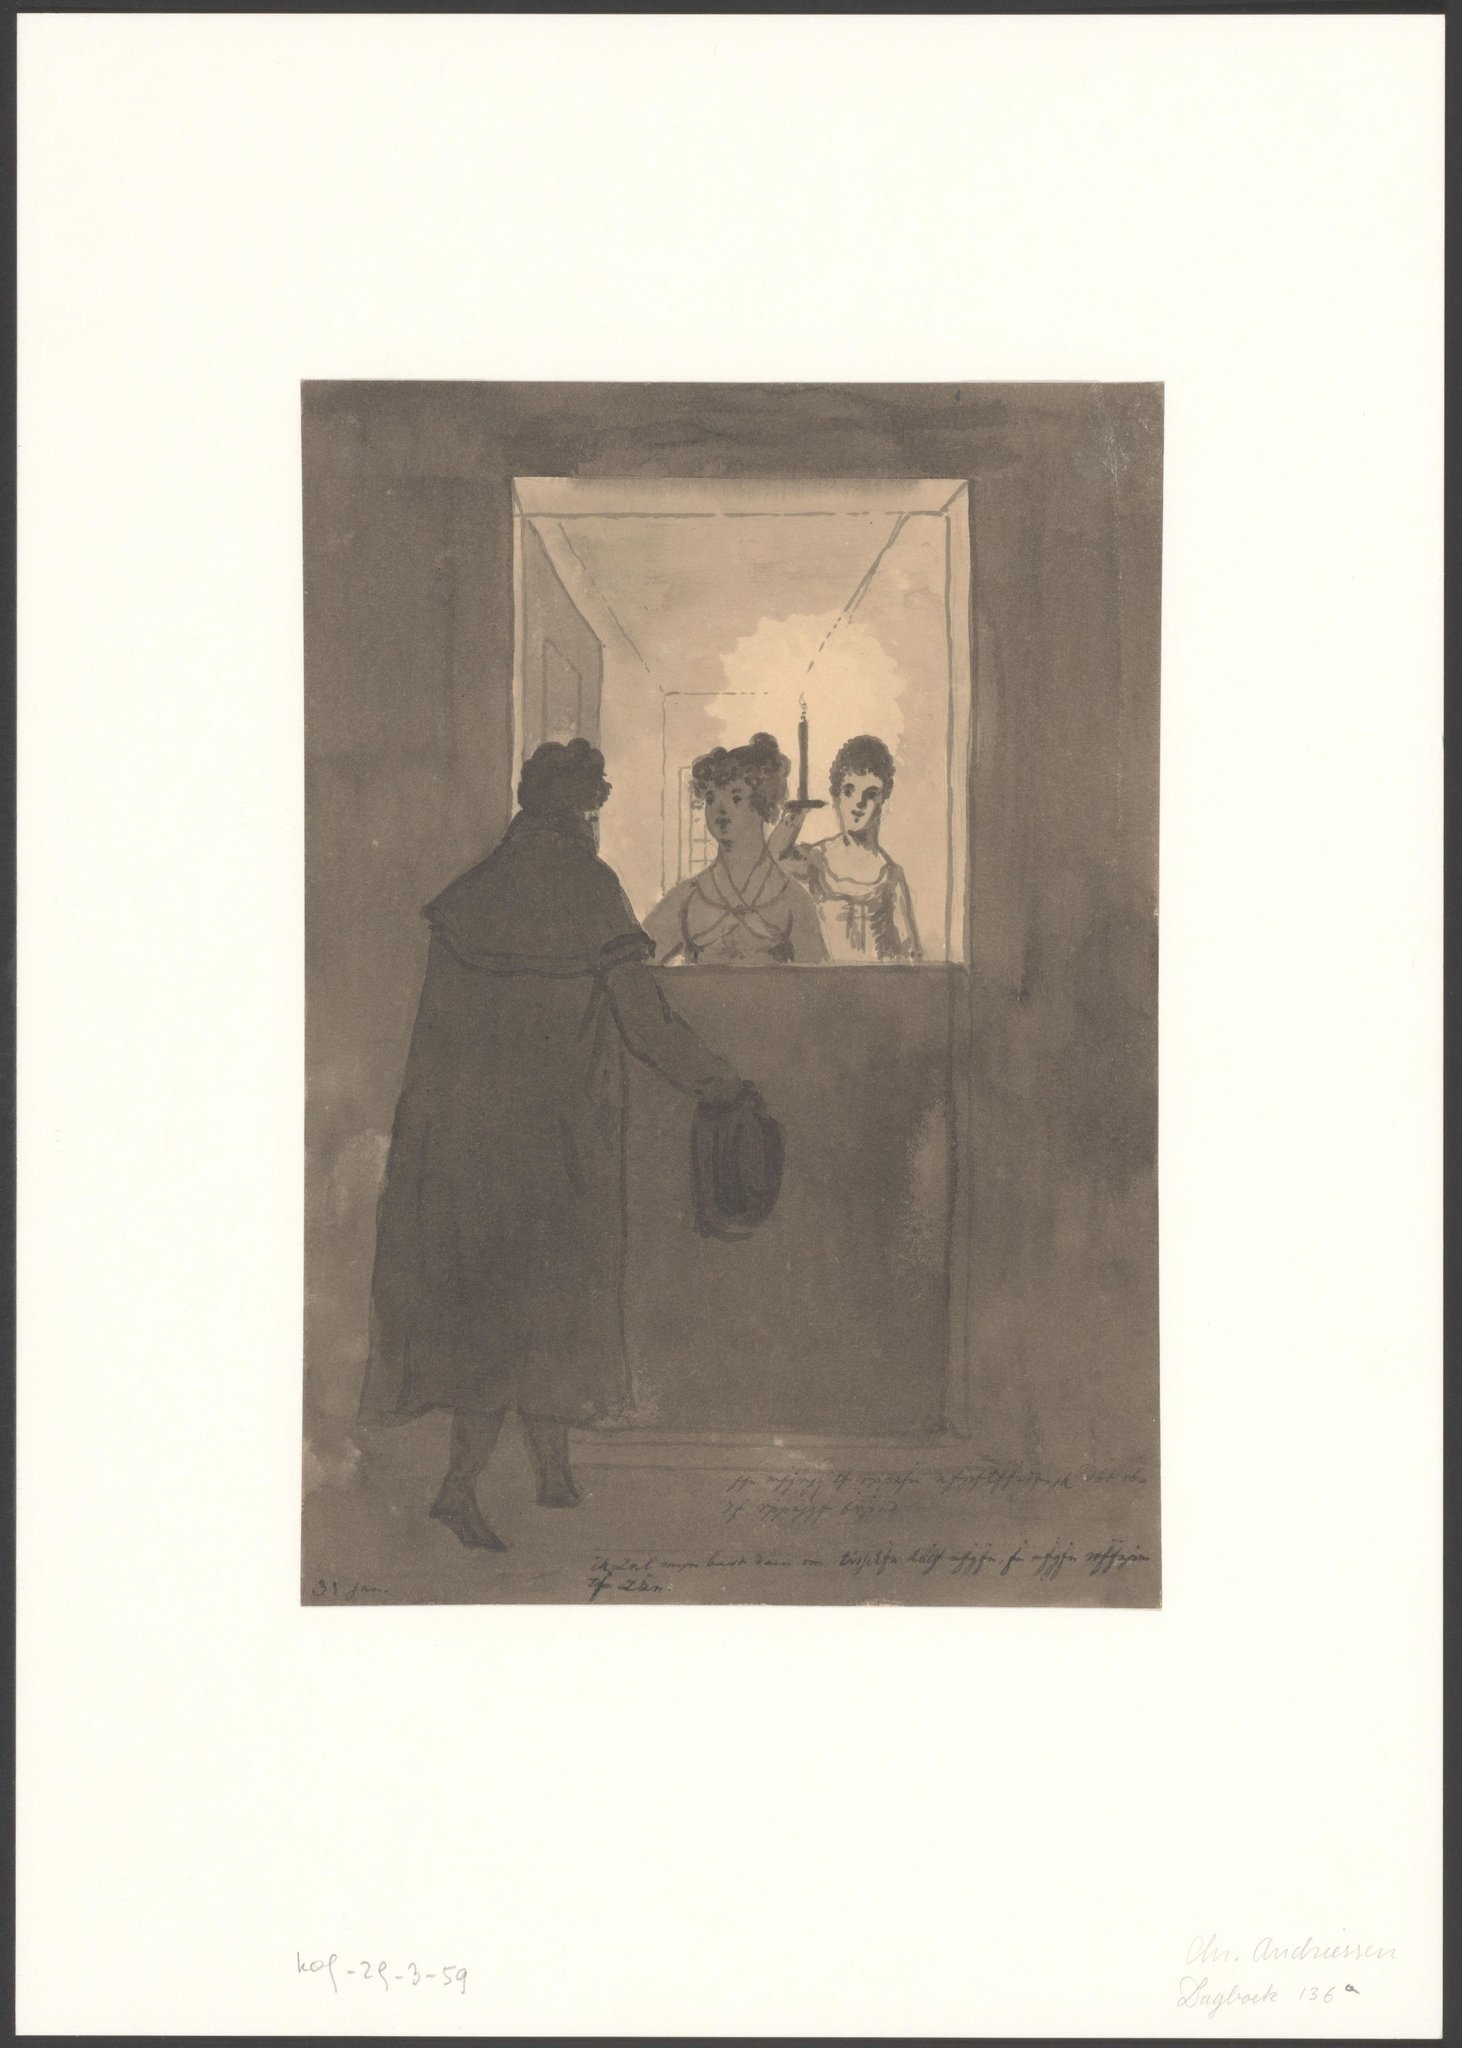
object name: drawing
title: Christiaan Andriessen staat in de avond voor de deur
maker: christiaan andriessen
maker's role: draughtsman, print maker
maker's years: 1775-1846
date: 1805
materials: ink, paper, pencil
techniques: brush, pen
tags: amsterdam, print maker, draughtsman, christiaan andriessen, open door, opening the door, candlestick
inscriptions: inscription: ‘J Andriessen’, inscription: ‘ik zal mijn best daar’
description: Dagboekblad uit het getekende dagboek dat Christiaan Andriessen bijhield van 1805 tot en met 1808.